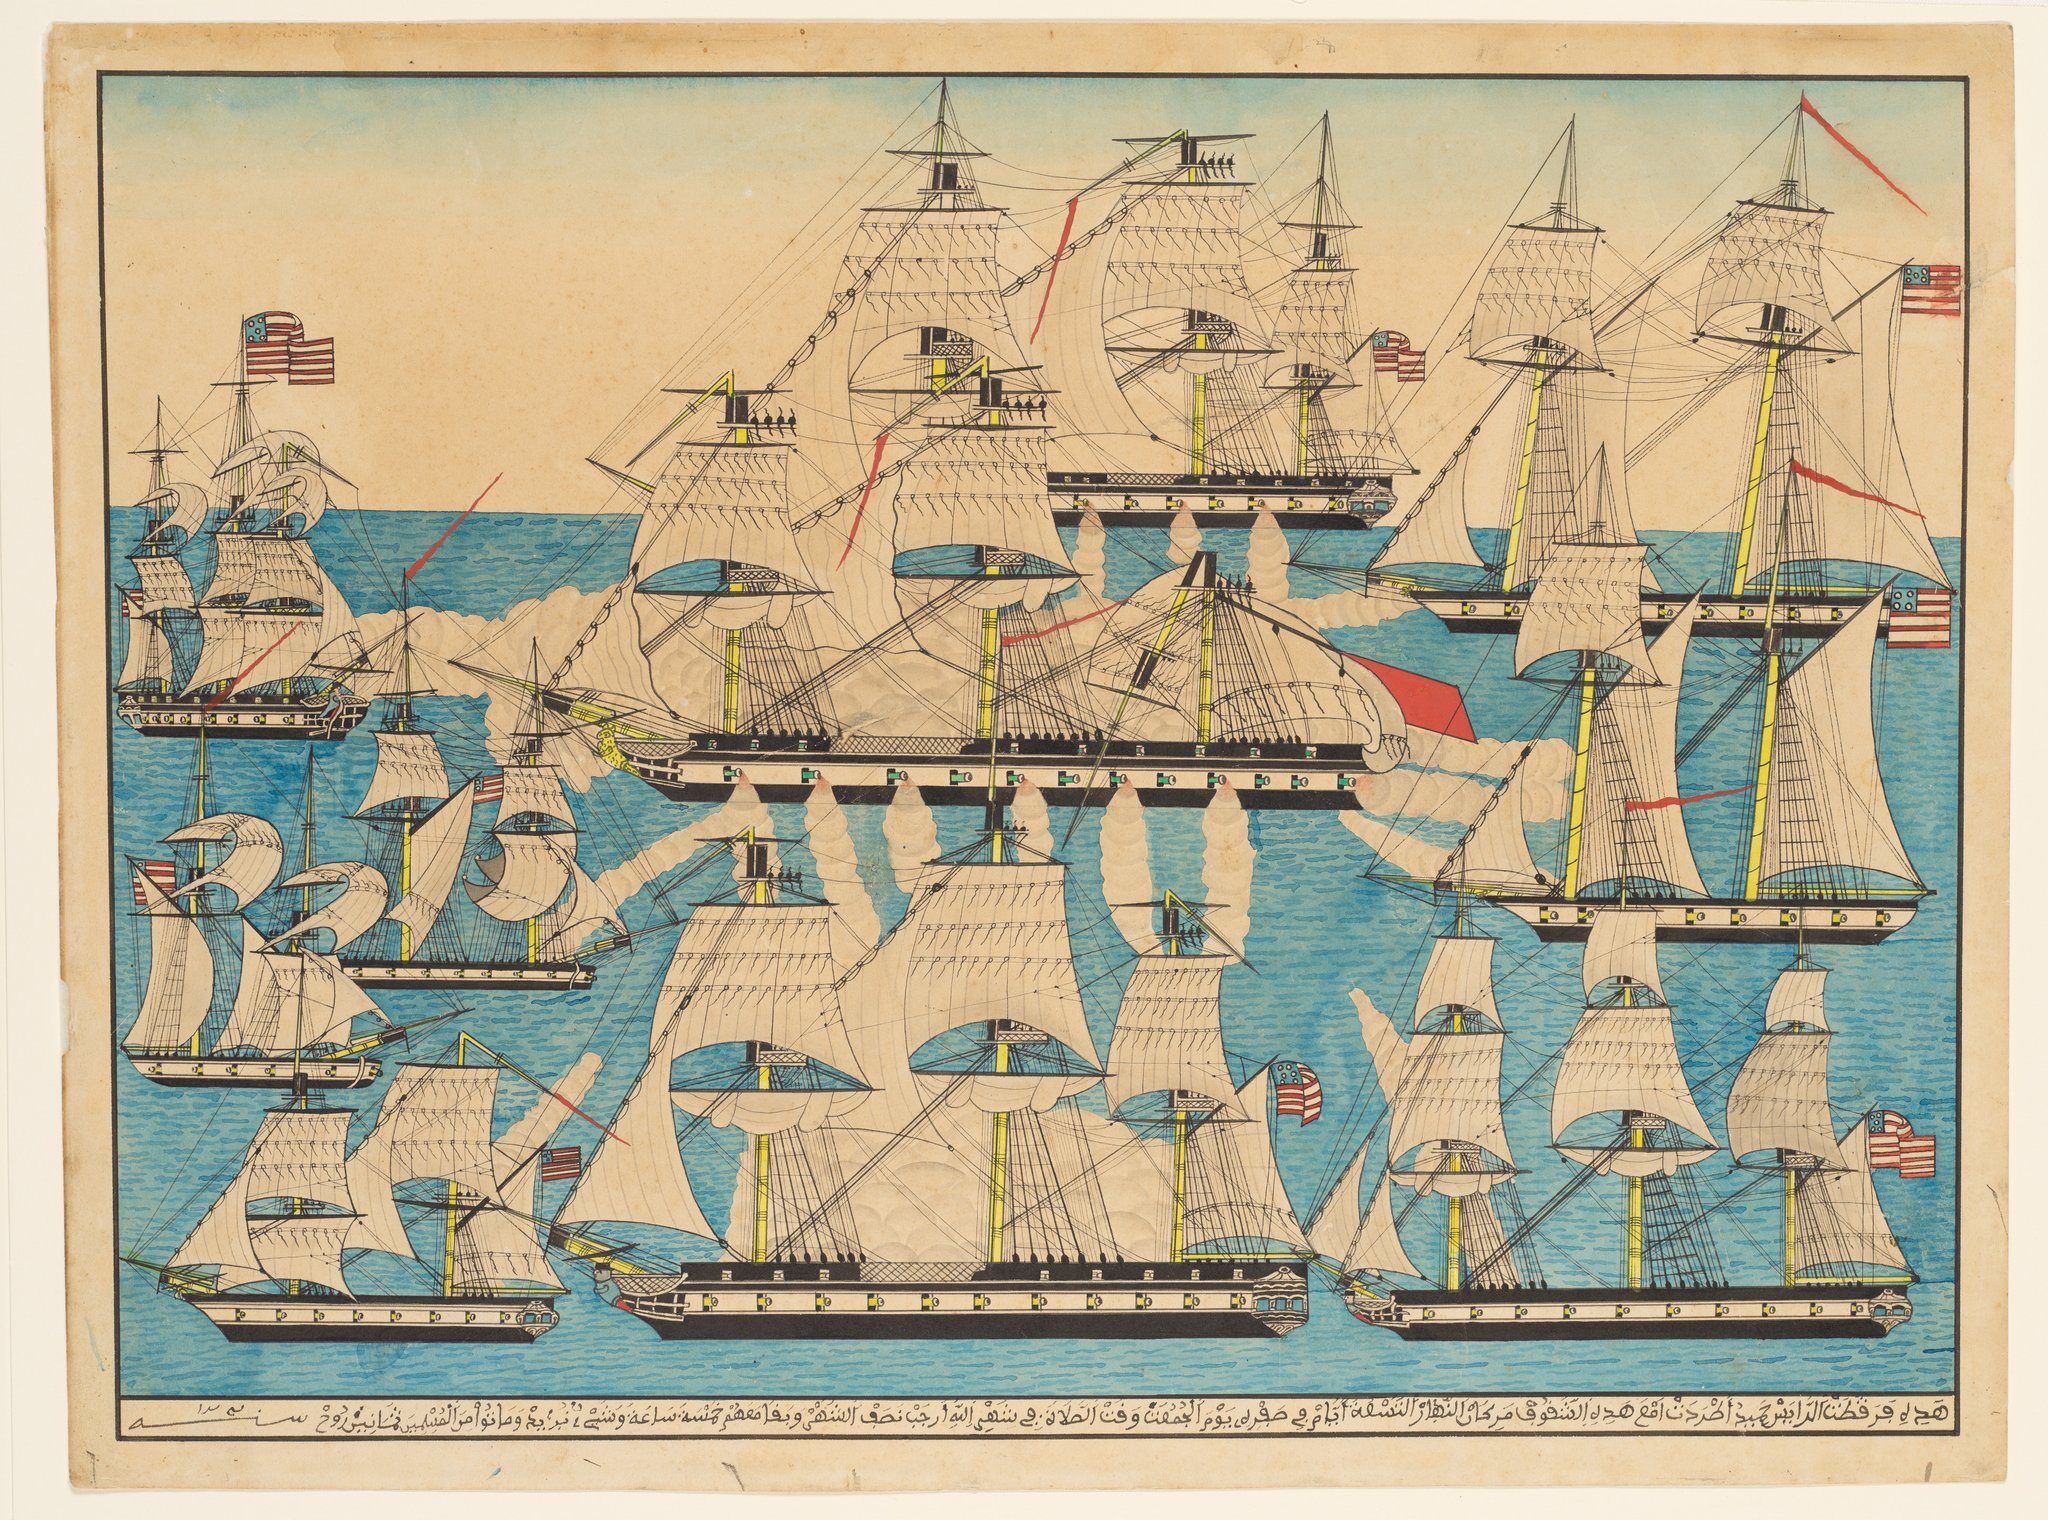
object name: illustrated single work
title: The American Fleet Defeating Rais Hamdu off Cape Gata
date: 1801-1900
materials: ink, paper, watercolor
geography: algeria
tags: ships